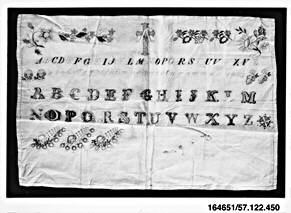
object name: sampler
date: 1801-1900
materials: cotton